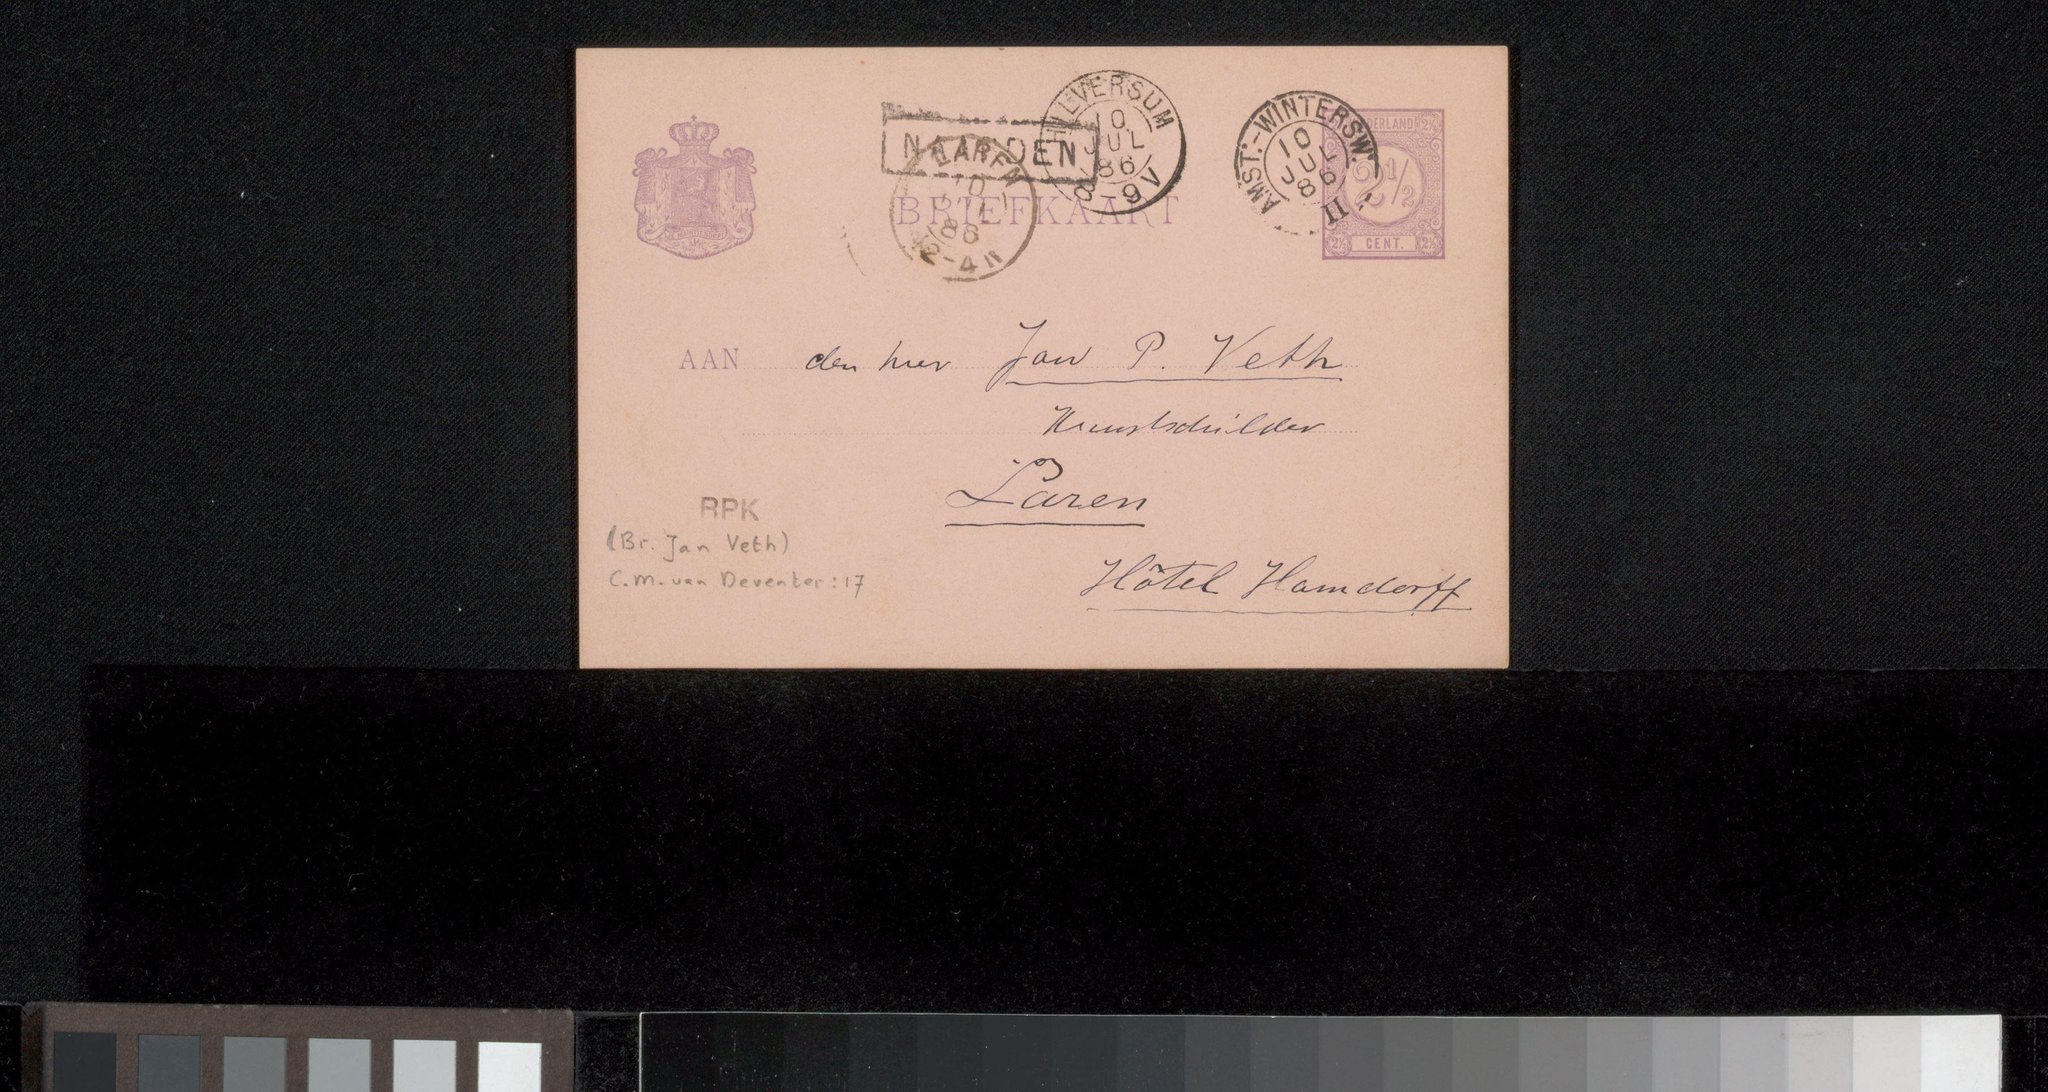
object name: postcard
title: Briefkaart aan Jan Veth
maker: chap van deventer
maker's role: kunstcriticus, scheikundige, schrijver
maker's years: 1860-1931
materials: cardboard, ink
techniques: pen, writing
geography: amsterdam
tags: dordrecht, painter, print maker, draughtsman, designer, jan veth, deventer, martha van vloten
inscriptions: collector's mark: ‘RPK’